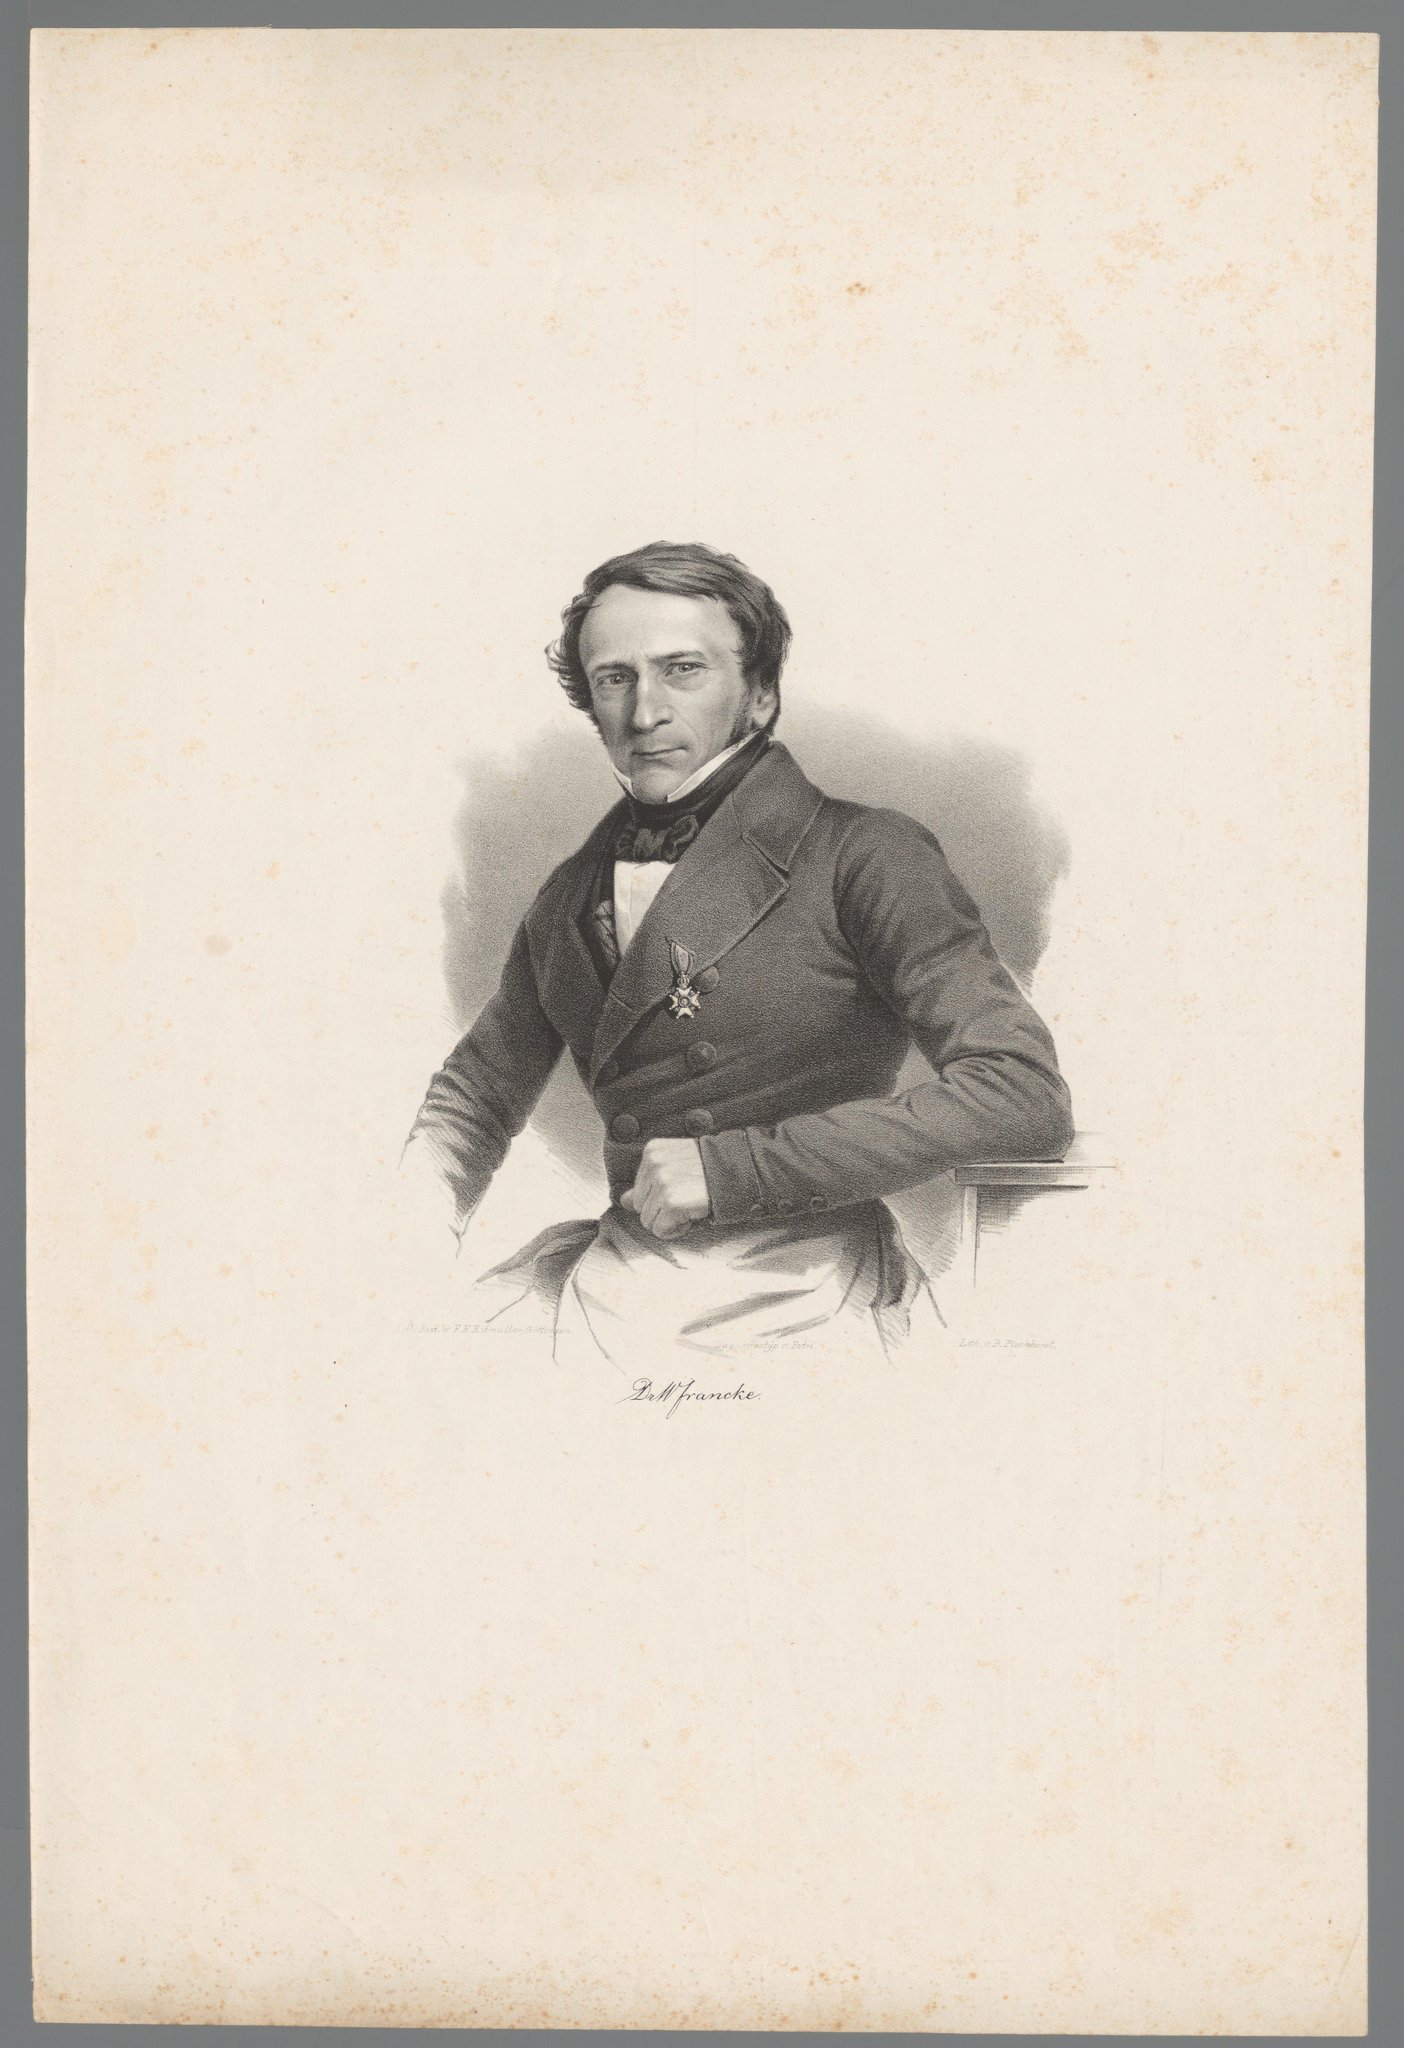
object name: print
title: Dr. W. Francke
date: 1835-1875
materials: paper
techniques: lithograph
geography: gottingen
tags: adult man, historical persons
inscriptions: collector's mark: Lugt 2228